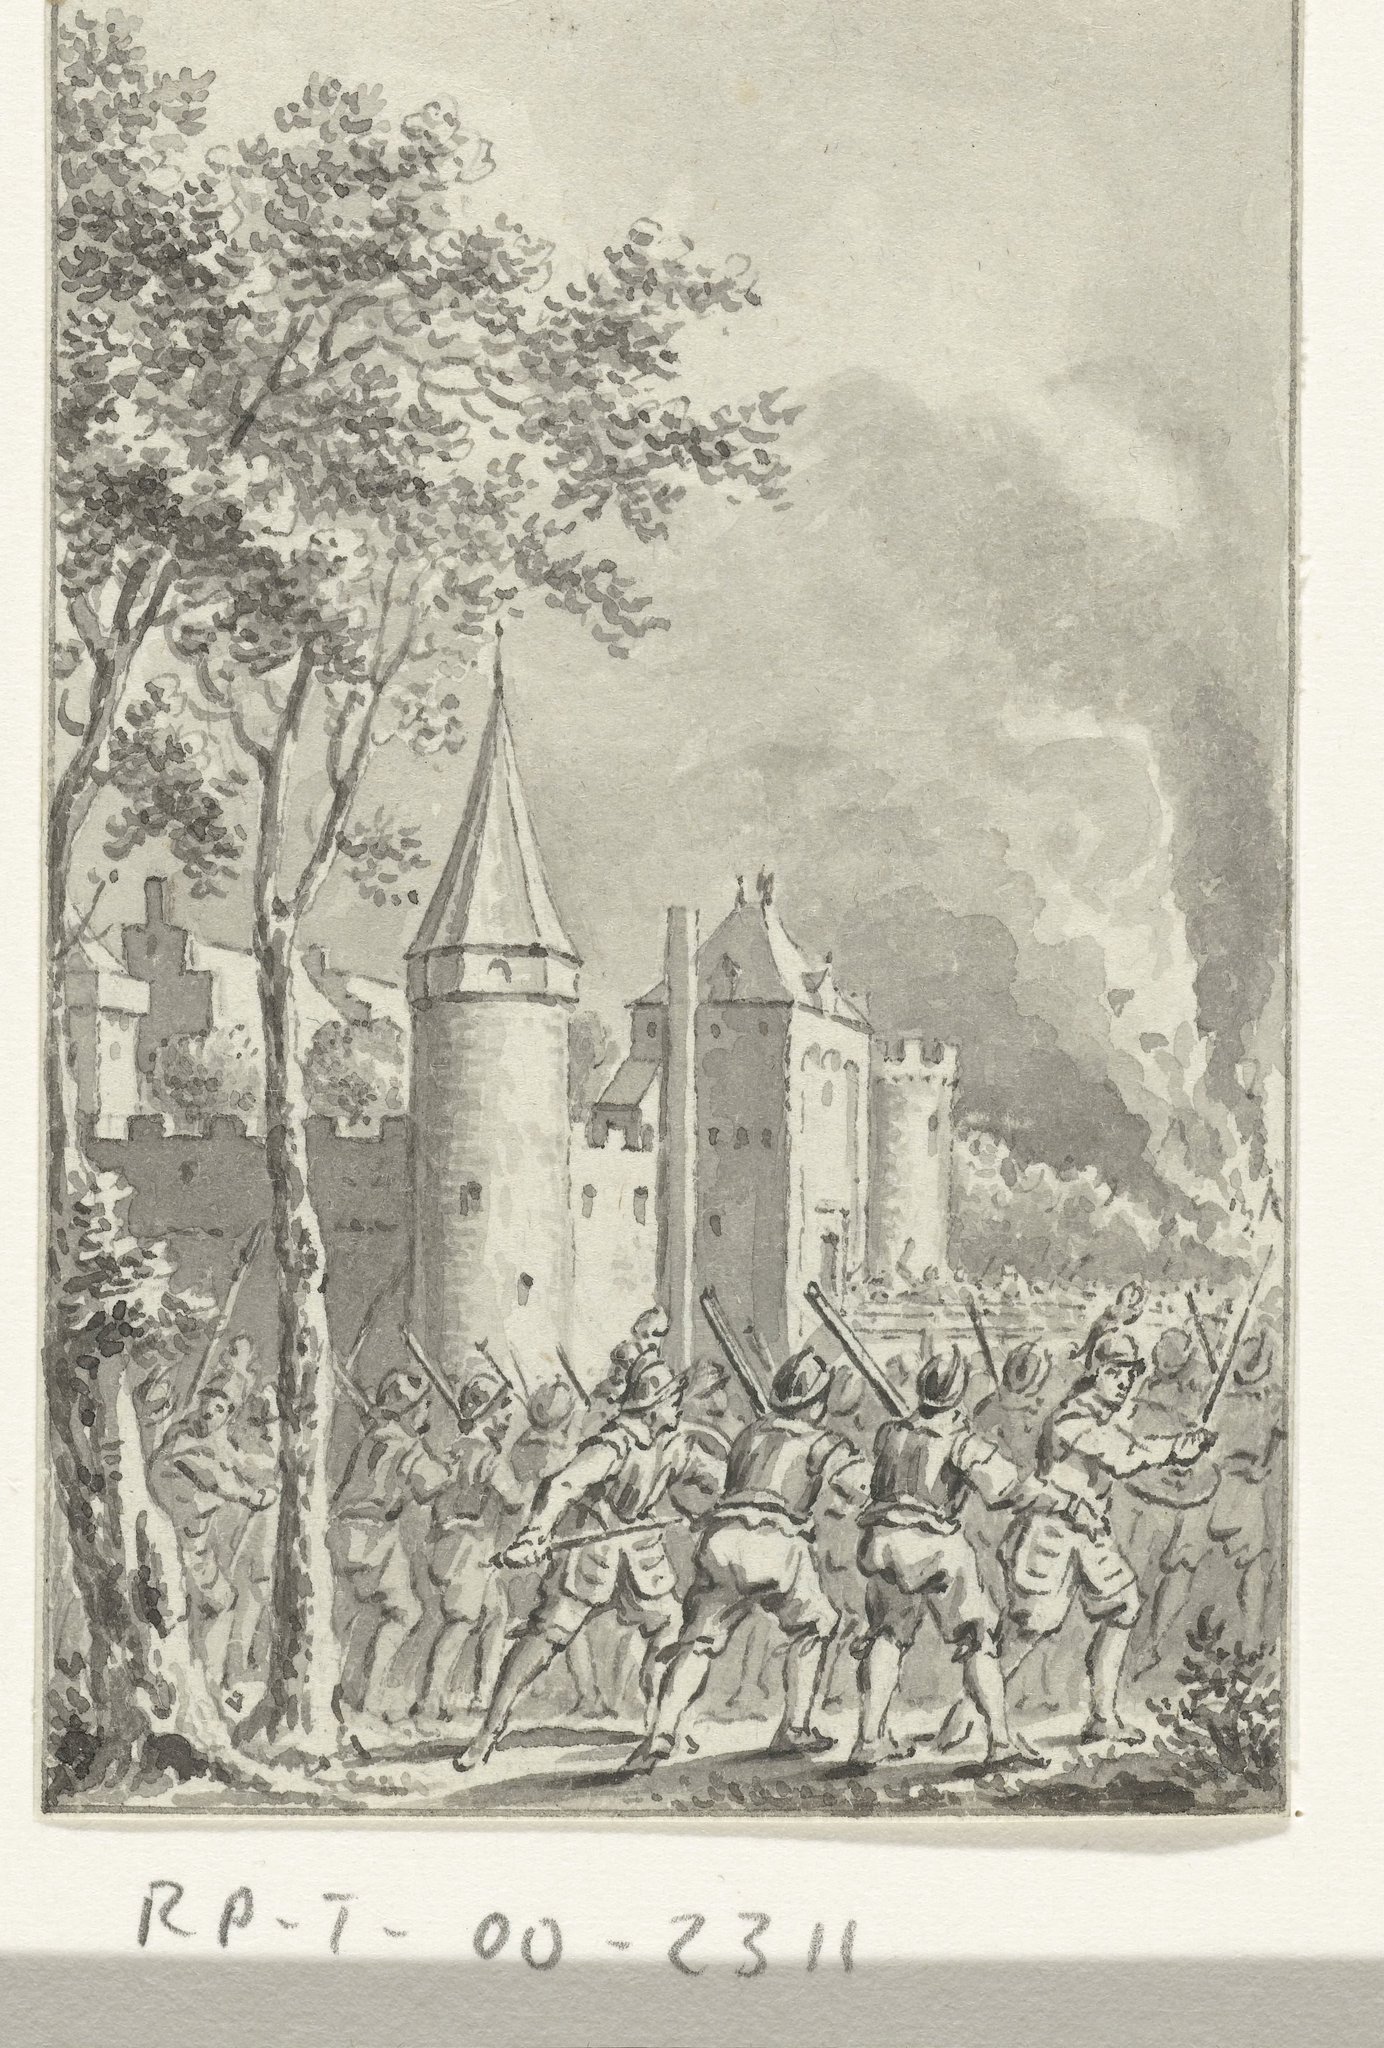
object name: history print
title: Belegering van het Muiderslot door Gelderse troepen, 1508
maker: jacobus buys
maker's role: draughtsman, print maker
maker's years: 1724-1801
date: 1778-1795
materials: ink, paper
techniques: brush, pen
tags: castle, siege, historical events and situations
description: Ontwerptekening voor illustratie in: J. Fokke, Geschiedenissen der Vereenigde Nederlanden voor de vaderlandsche jeugd, Johannes Allart, Amsterdam 1783-1795, 25 delen, dl. III, pl. IV.